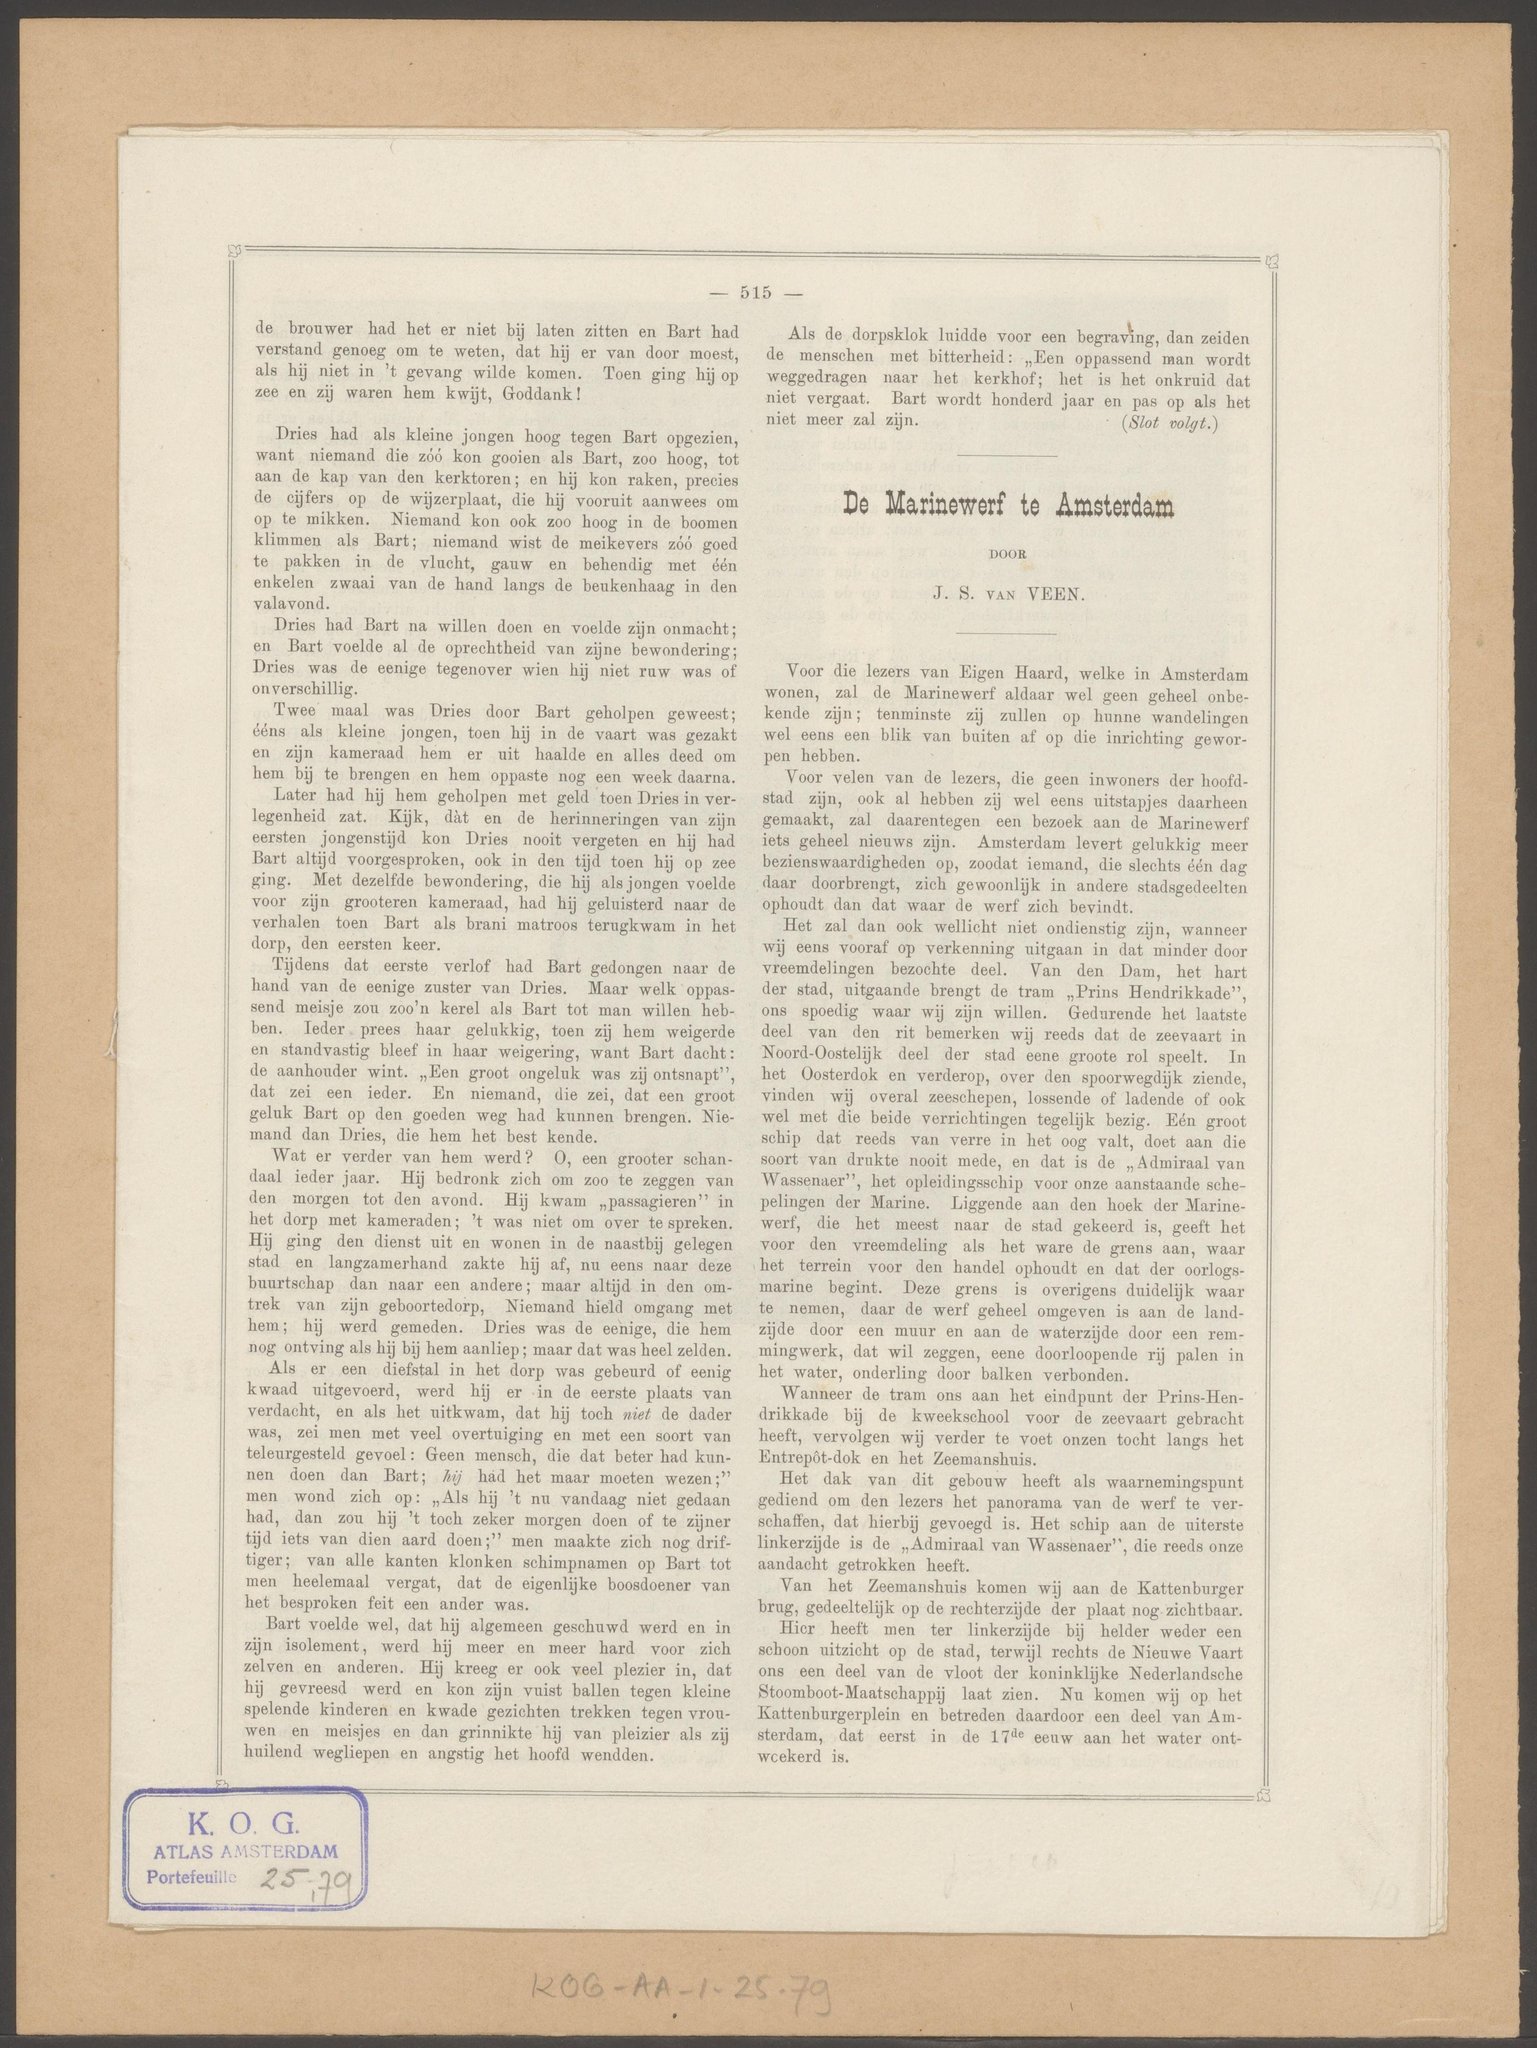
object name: article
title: Marinewerf te Amsterdam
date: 1805-1895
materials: paper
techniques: letterpress printing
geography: haarlem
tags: crew ~ ship, sailing-ship, sailing-boat, parts of ship's exterior - cc - more than one ship, façade (of house or building), shipyard, shipdock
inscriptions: collector's mark: ‘25.79’ Lugt 1641b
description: Object bestaande uit veertien pagina's: 515-518, 531-534 en 547-551, met twaalf autotypieën. Onderwerpsrubriek binnen de Atlas Amsterdam: Krijgswezen I: De Admiraliteit van Amsterdam, A. Admiraliteitsgebouwen.